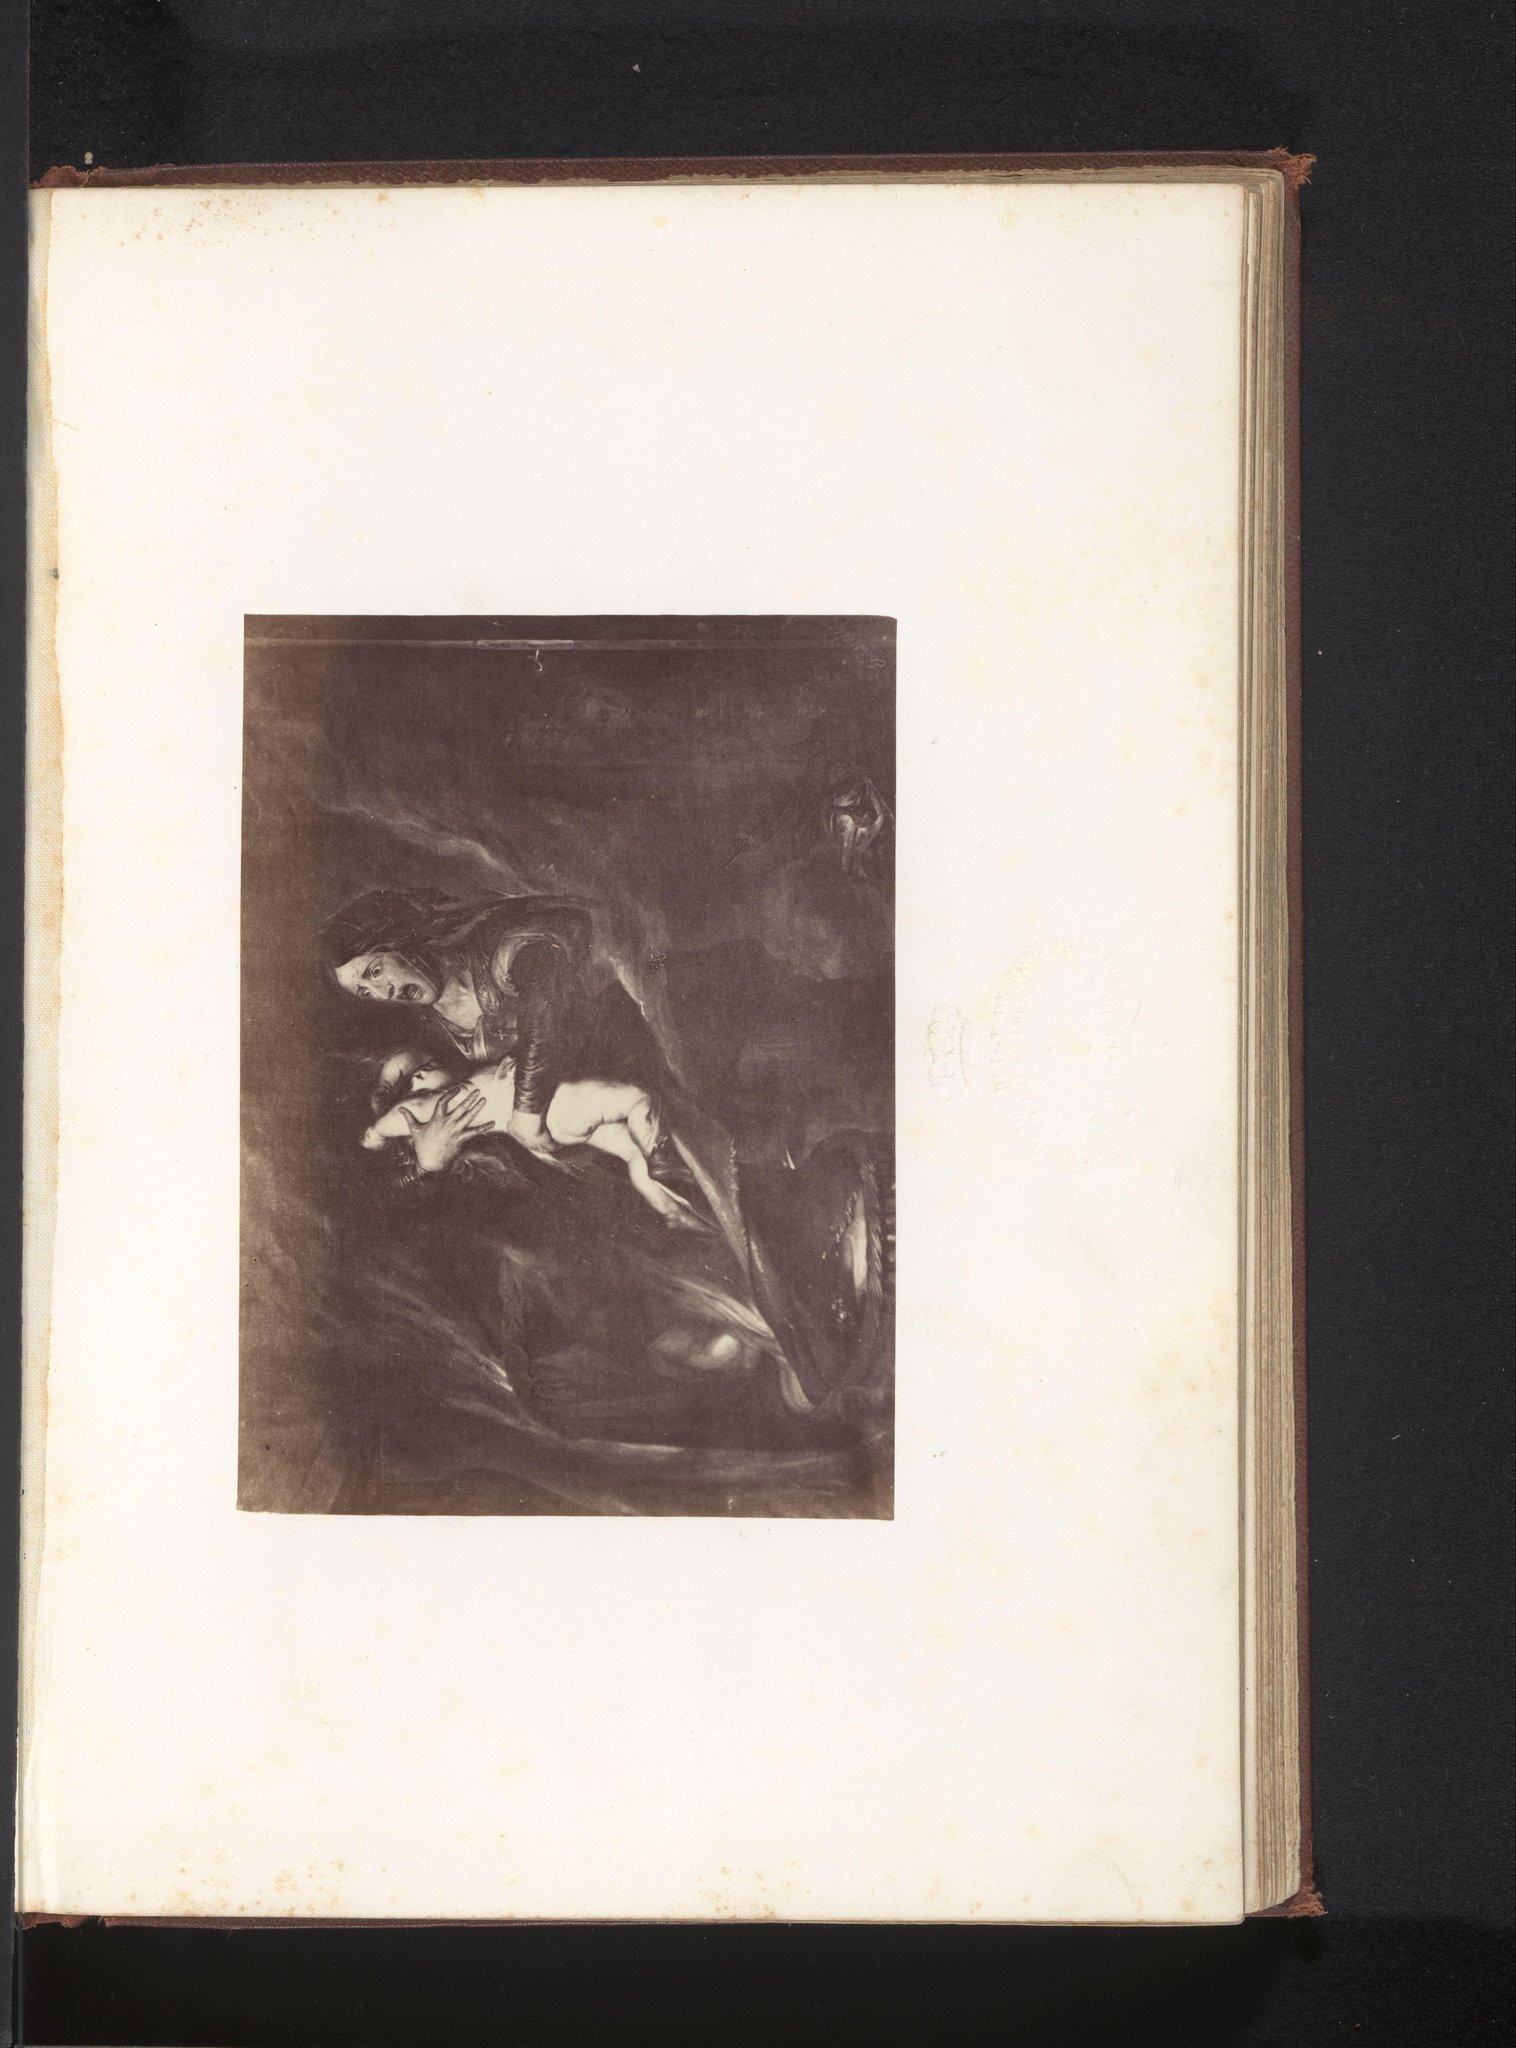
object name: photograph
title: Fotoreproductie van Het verbrande door Antoine Wiertz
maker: edmond fierlants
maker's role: fotograaf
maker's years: 1819-1869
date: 1863-1868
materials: photographic support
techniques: albumen print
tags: child, burning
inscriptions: check stamp: ‘SOCIÉTÉ ROYALE BELGE DE PHOTOGRAPHIE/ 69, RUE KEYENVELD/ BRUXELLES’